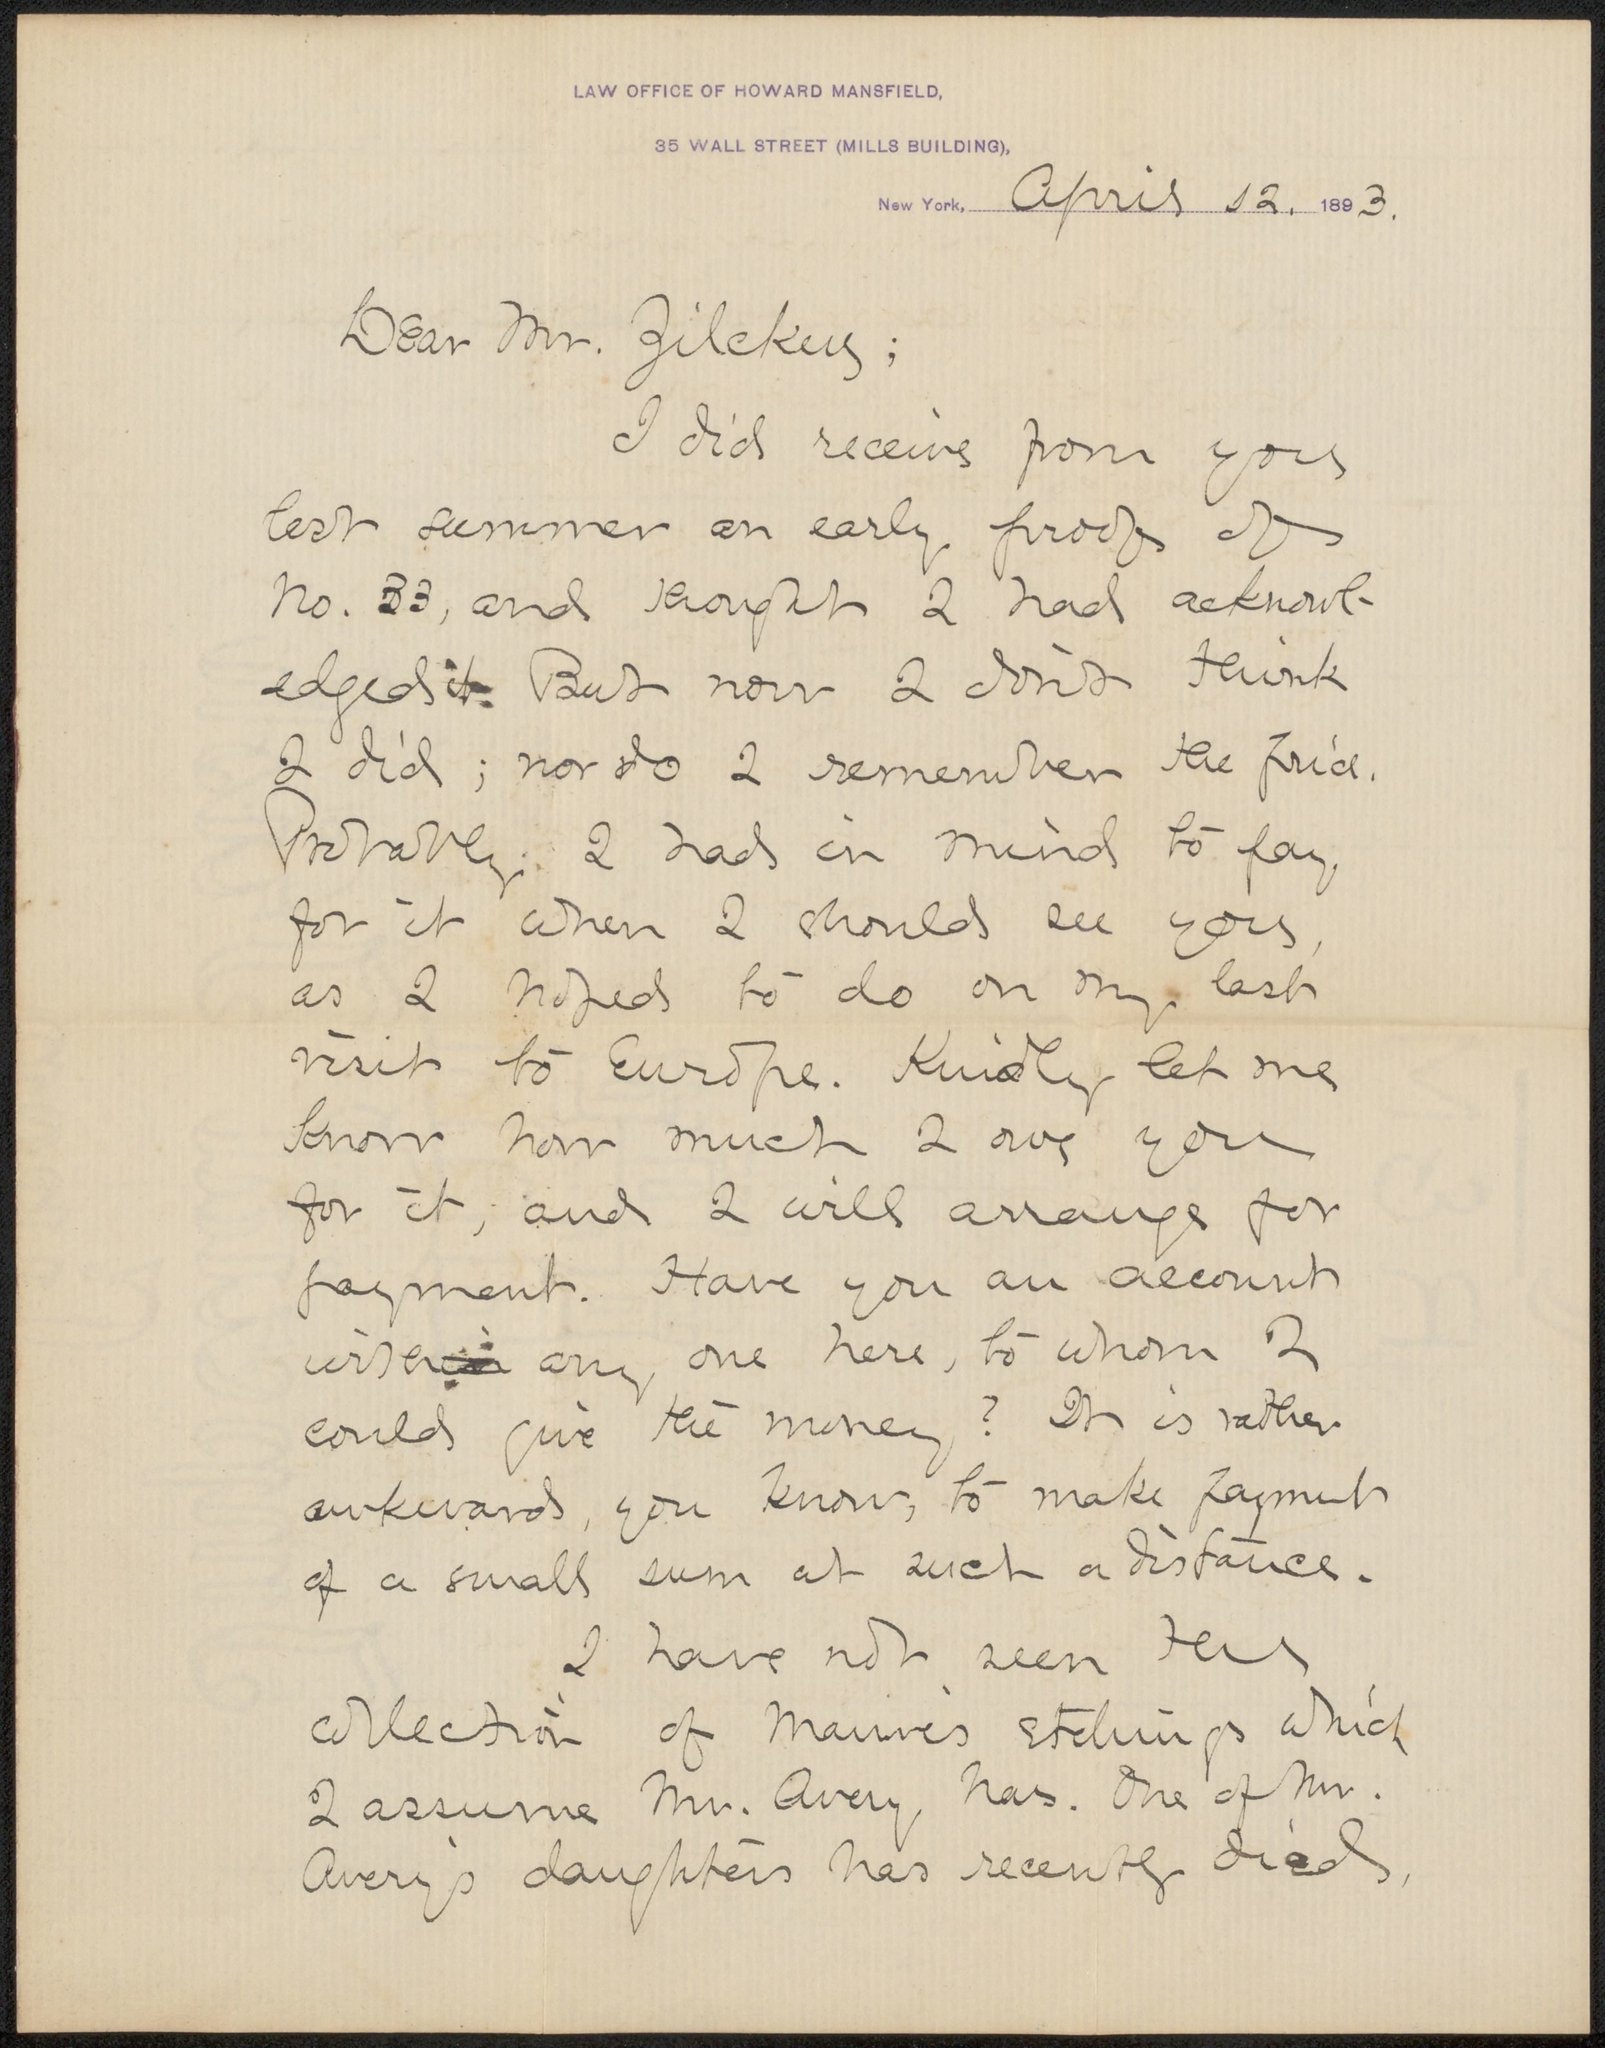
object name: letter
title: Brief aan Philip Zilcken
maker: howard mansfield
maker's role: jurist, verzamelaar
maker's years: 1849-1932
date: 1893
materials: ink, paper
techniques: pen, printing, writing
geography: new york city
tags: arnhem, painter, draughtsman, anton mauve, print maker, anders leonard zorn, samuel putnam avery, richard austin rice, philip zilcken, the graphic arts, money, new york (city), europe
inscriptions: watermark